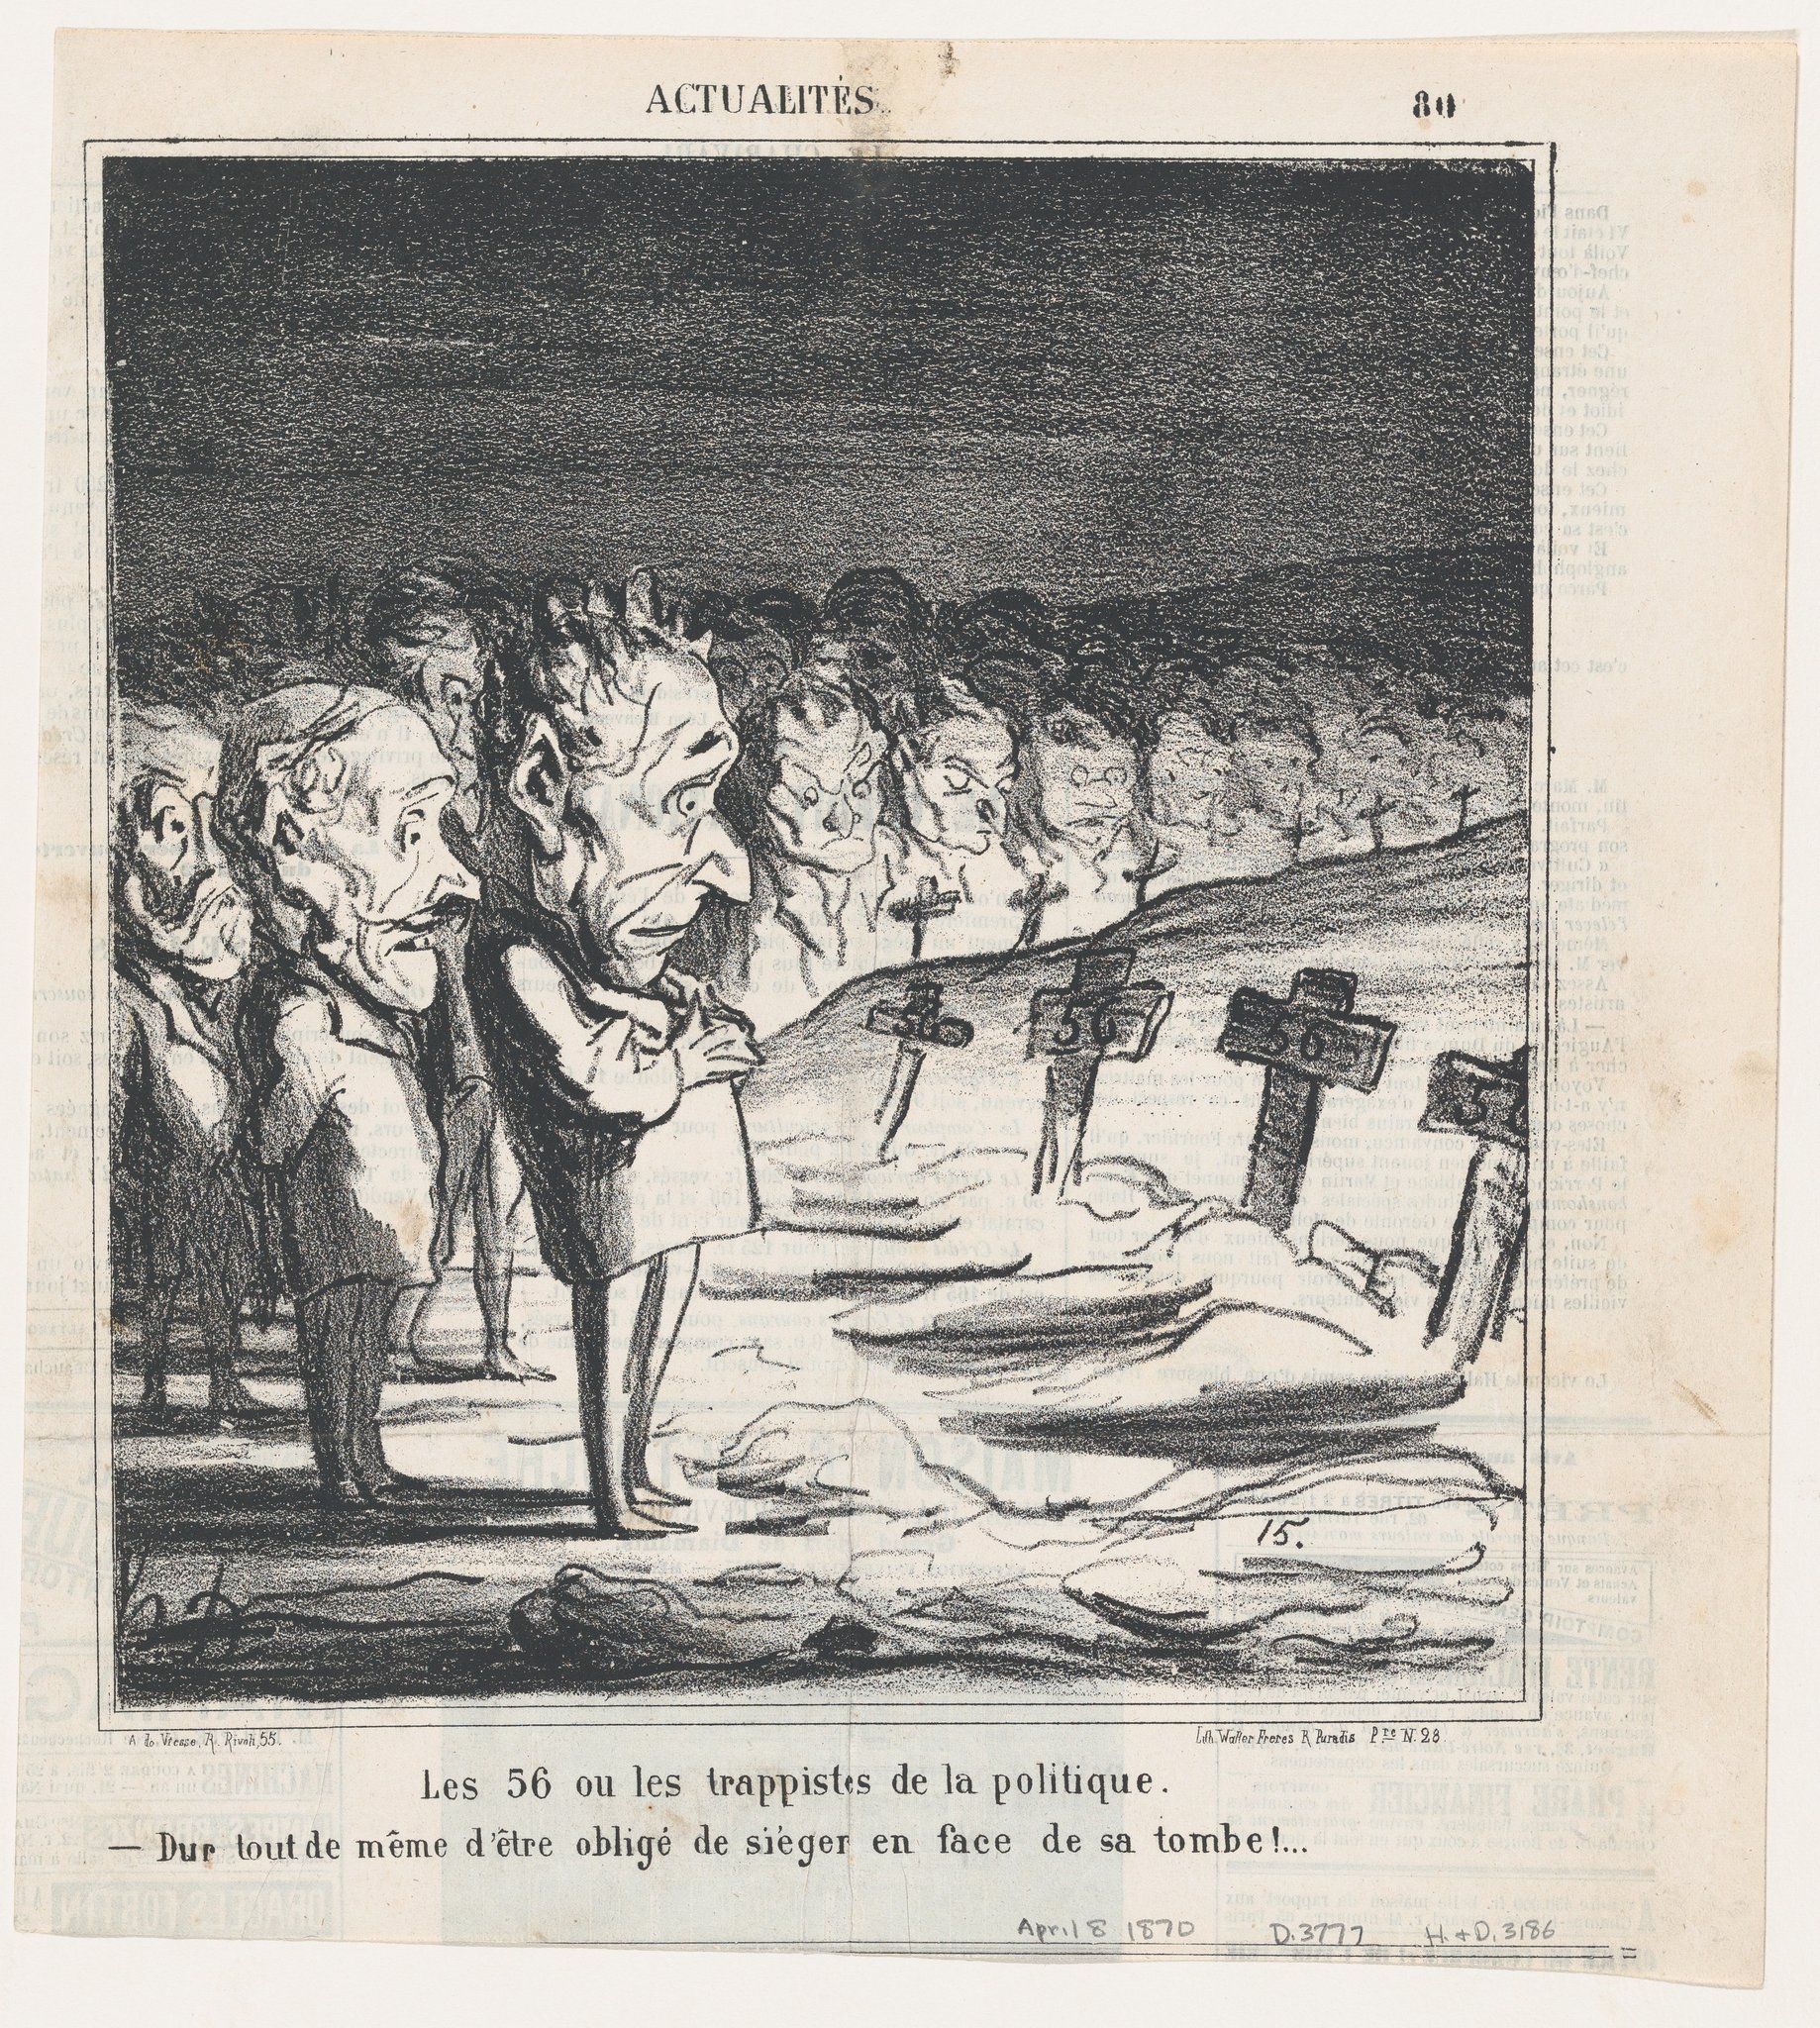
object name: print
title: The 56, or the trappists of politics: –Tough to have a session in front of your own grave!, from 'News of the day,' published in Le Charivari, April 8, 1870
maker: honoré daumier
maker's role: artist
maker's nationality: french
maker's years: 1808-1879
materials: paper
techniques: lithograph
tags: satire,burial grounds,men,funerals,crowd